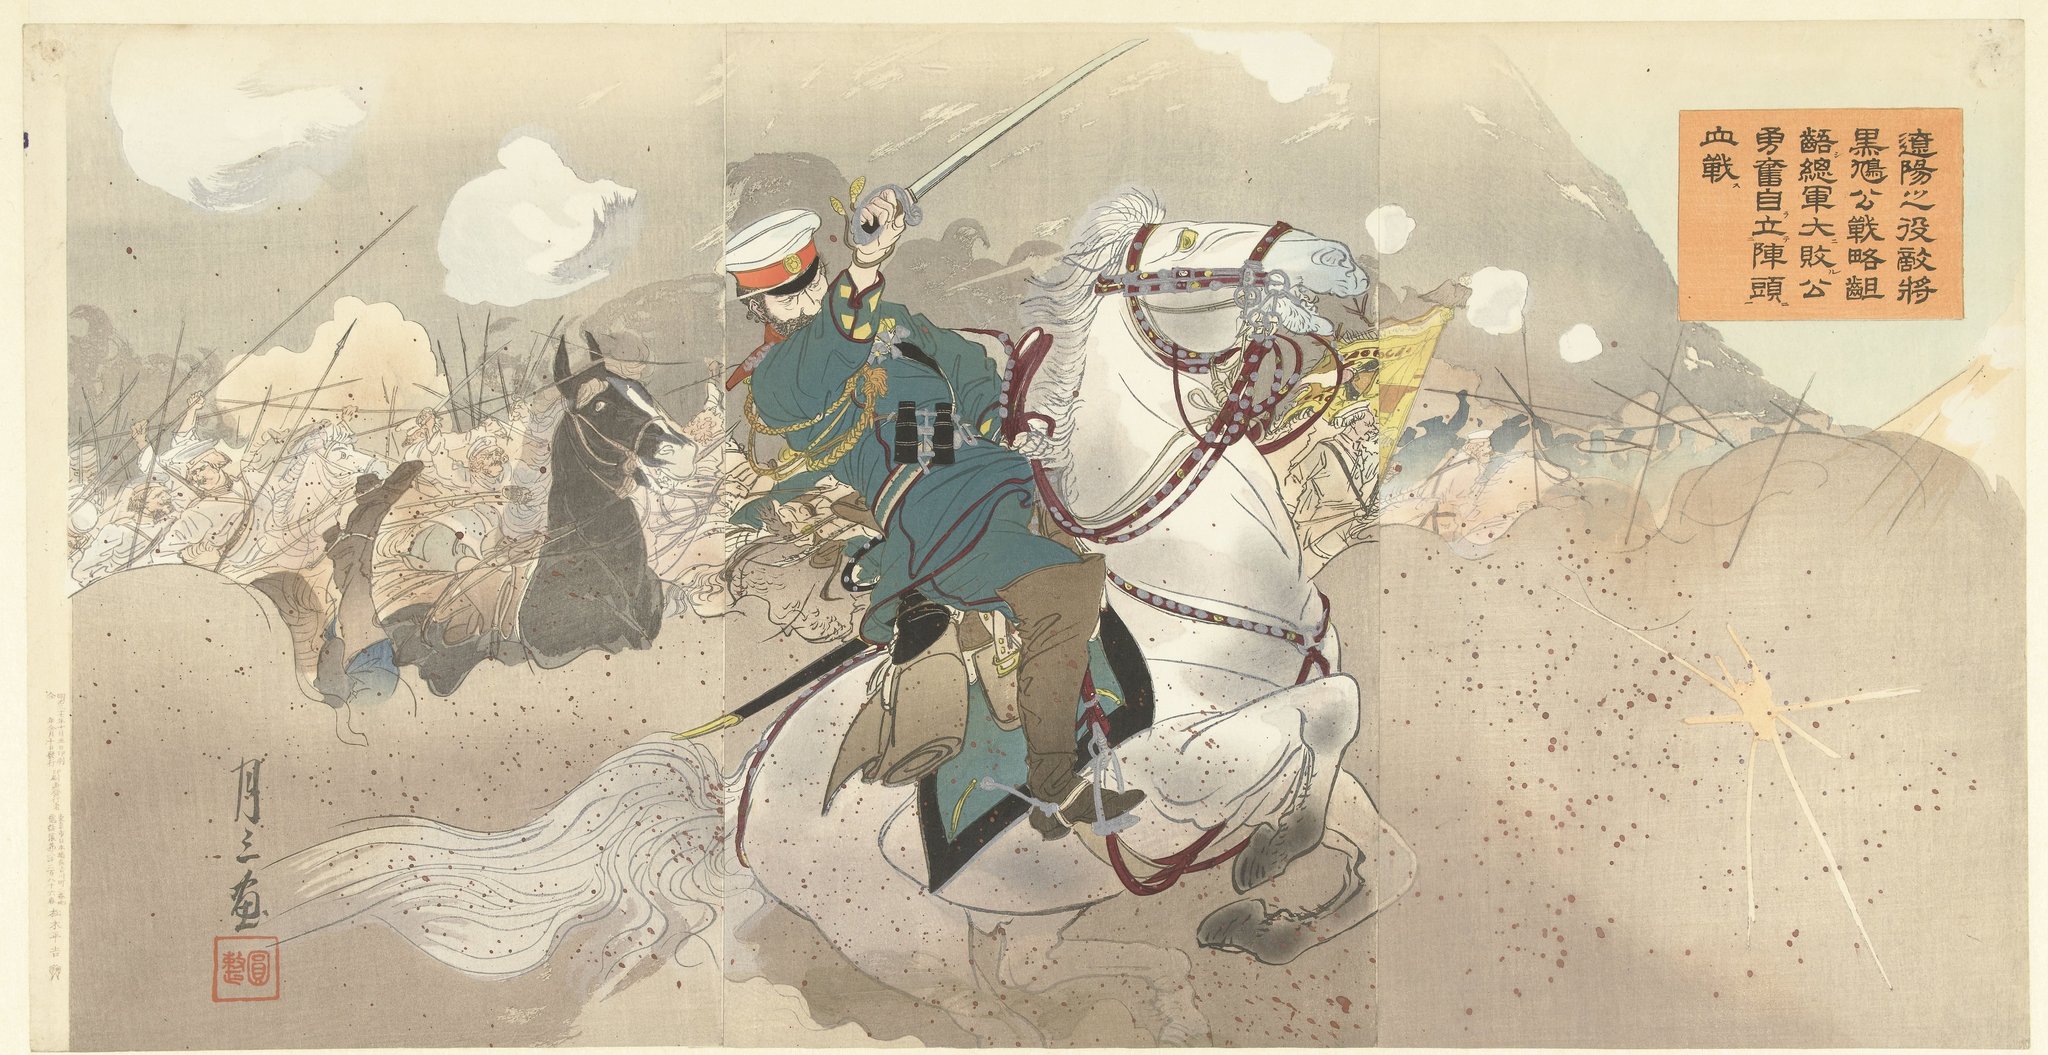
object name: triptych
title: Ondanks de onlogische strategie van generaal Kuropatkin bij de slag van Shaho en de verpletterende nederlaag van zijn leger, vecht hij dapper door.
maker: gessan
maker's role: print maker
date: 1904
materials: paper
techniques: woodcut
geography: japan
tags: battle, war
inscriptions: collector's mark: Lugt 2760, collector's mark: Lugt 2228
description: De Russische generaal Kuropatkin met getrokken zwaard, op een wit paard, zijn troepen aanvoerend in een bloederige strijd tegen de Japanners.